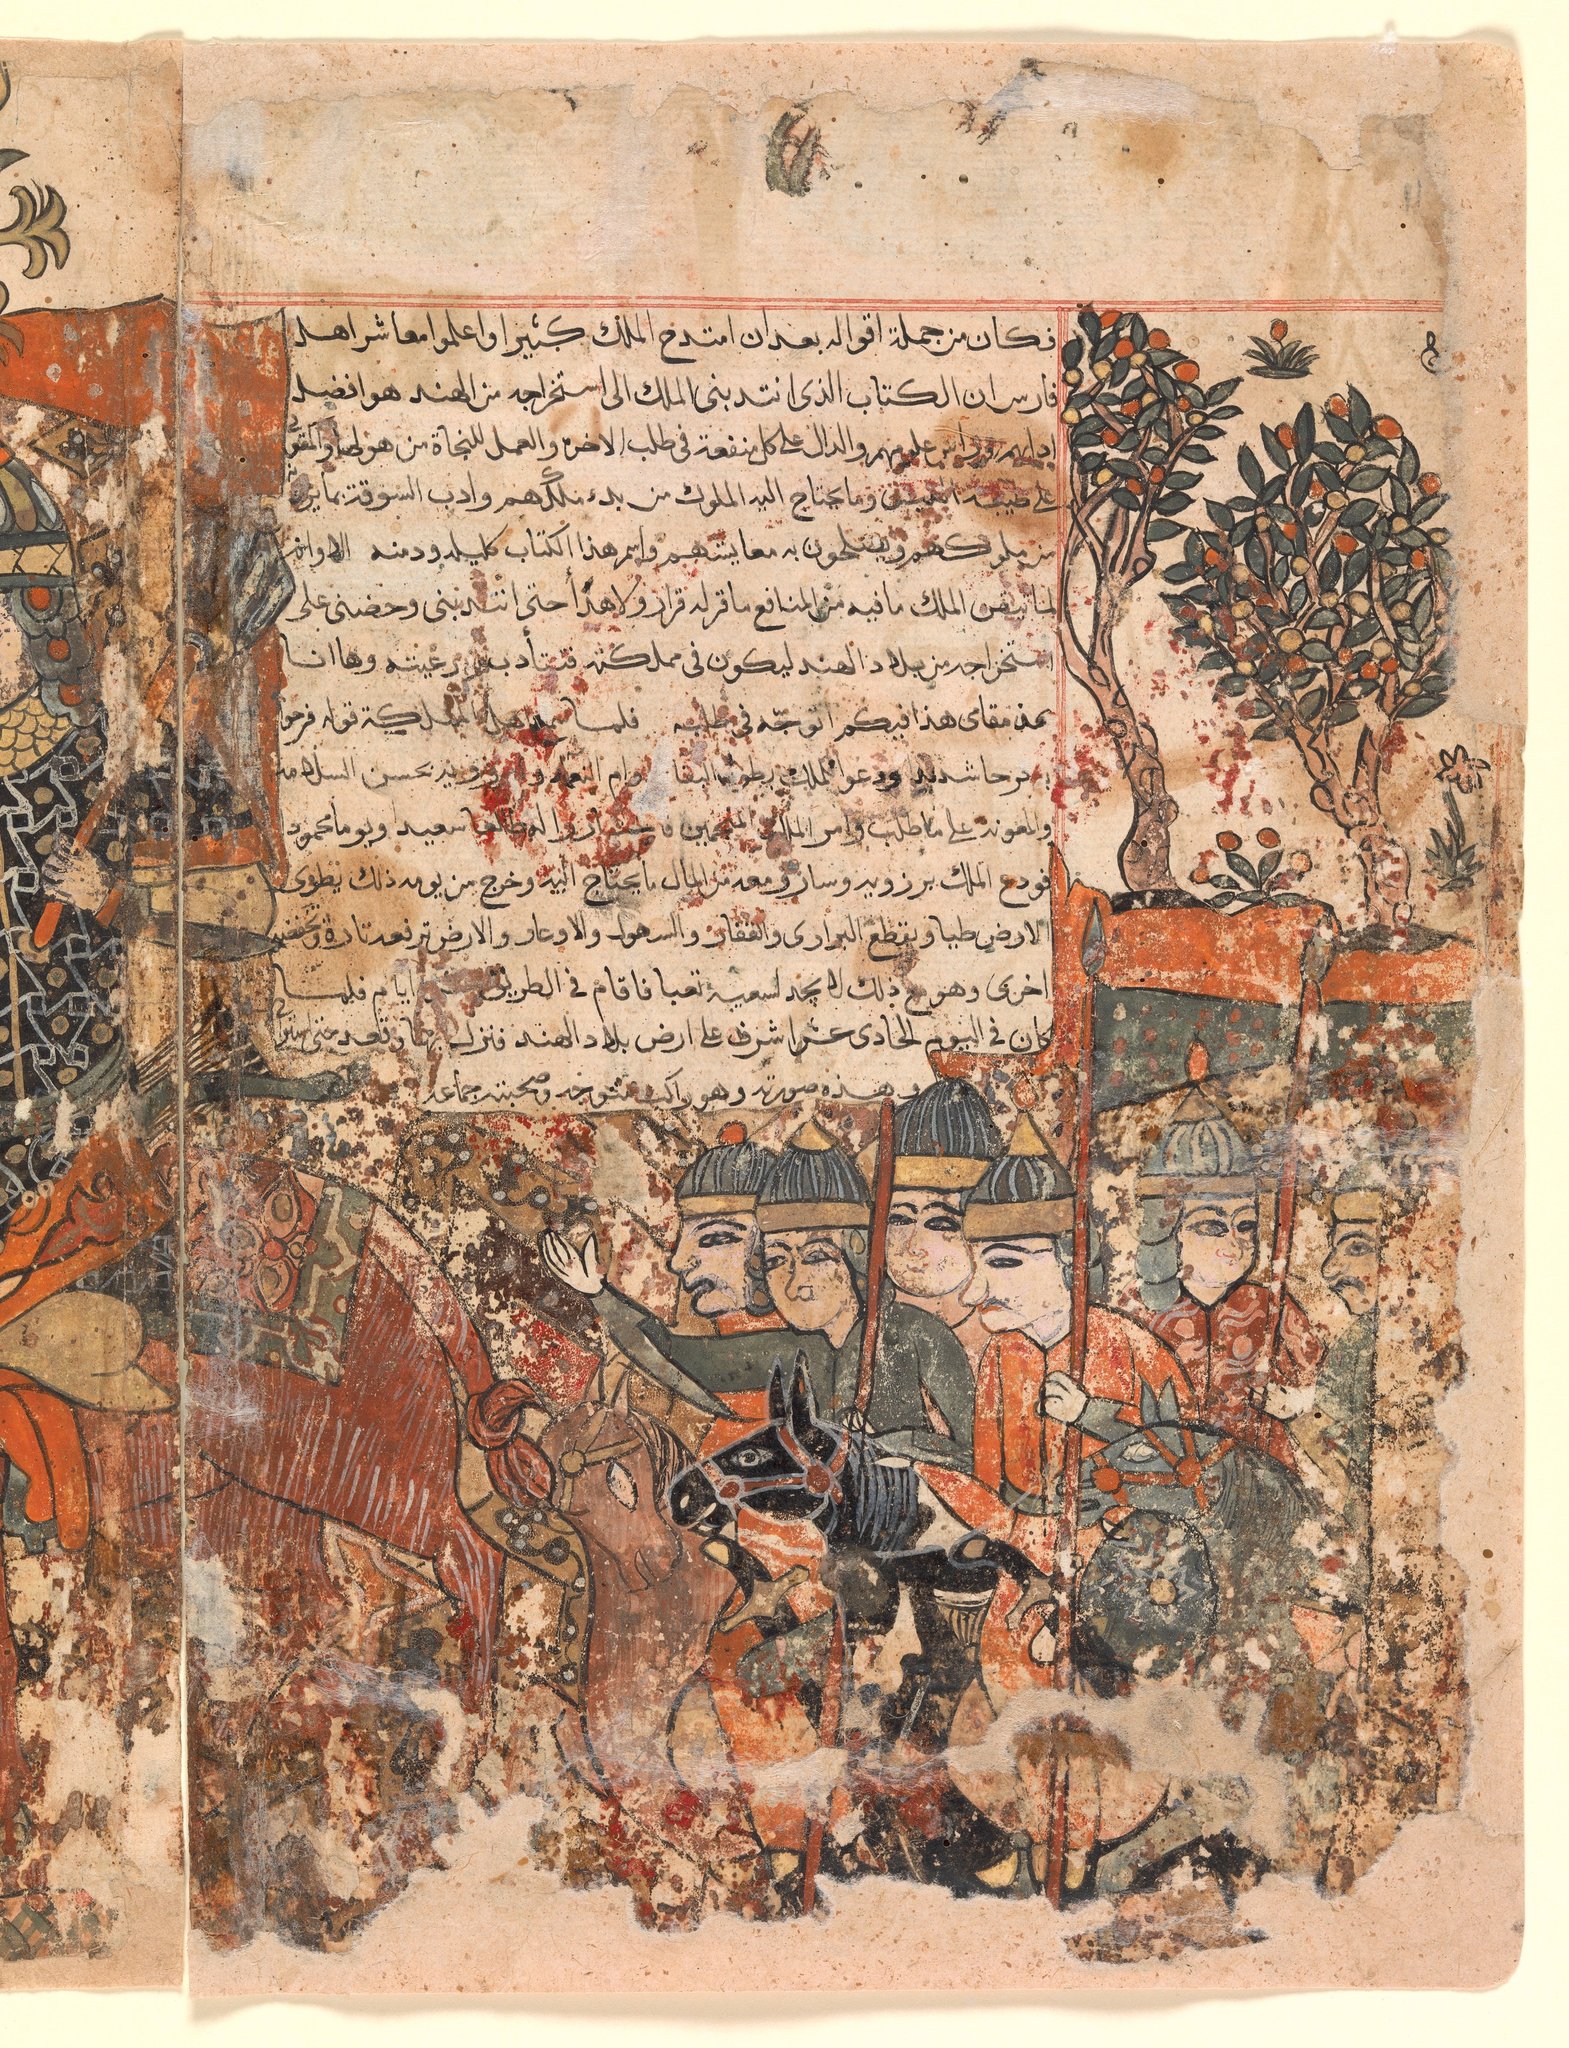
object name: folio from an illustrated manuscript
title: "Burzuya's Mission" Folio 5v, 6r from a Kalila Wa Dimna of Bidpai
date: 1526-1550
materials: ink, paper, watercolor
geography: india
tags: soldiers,horses